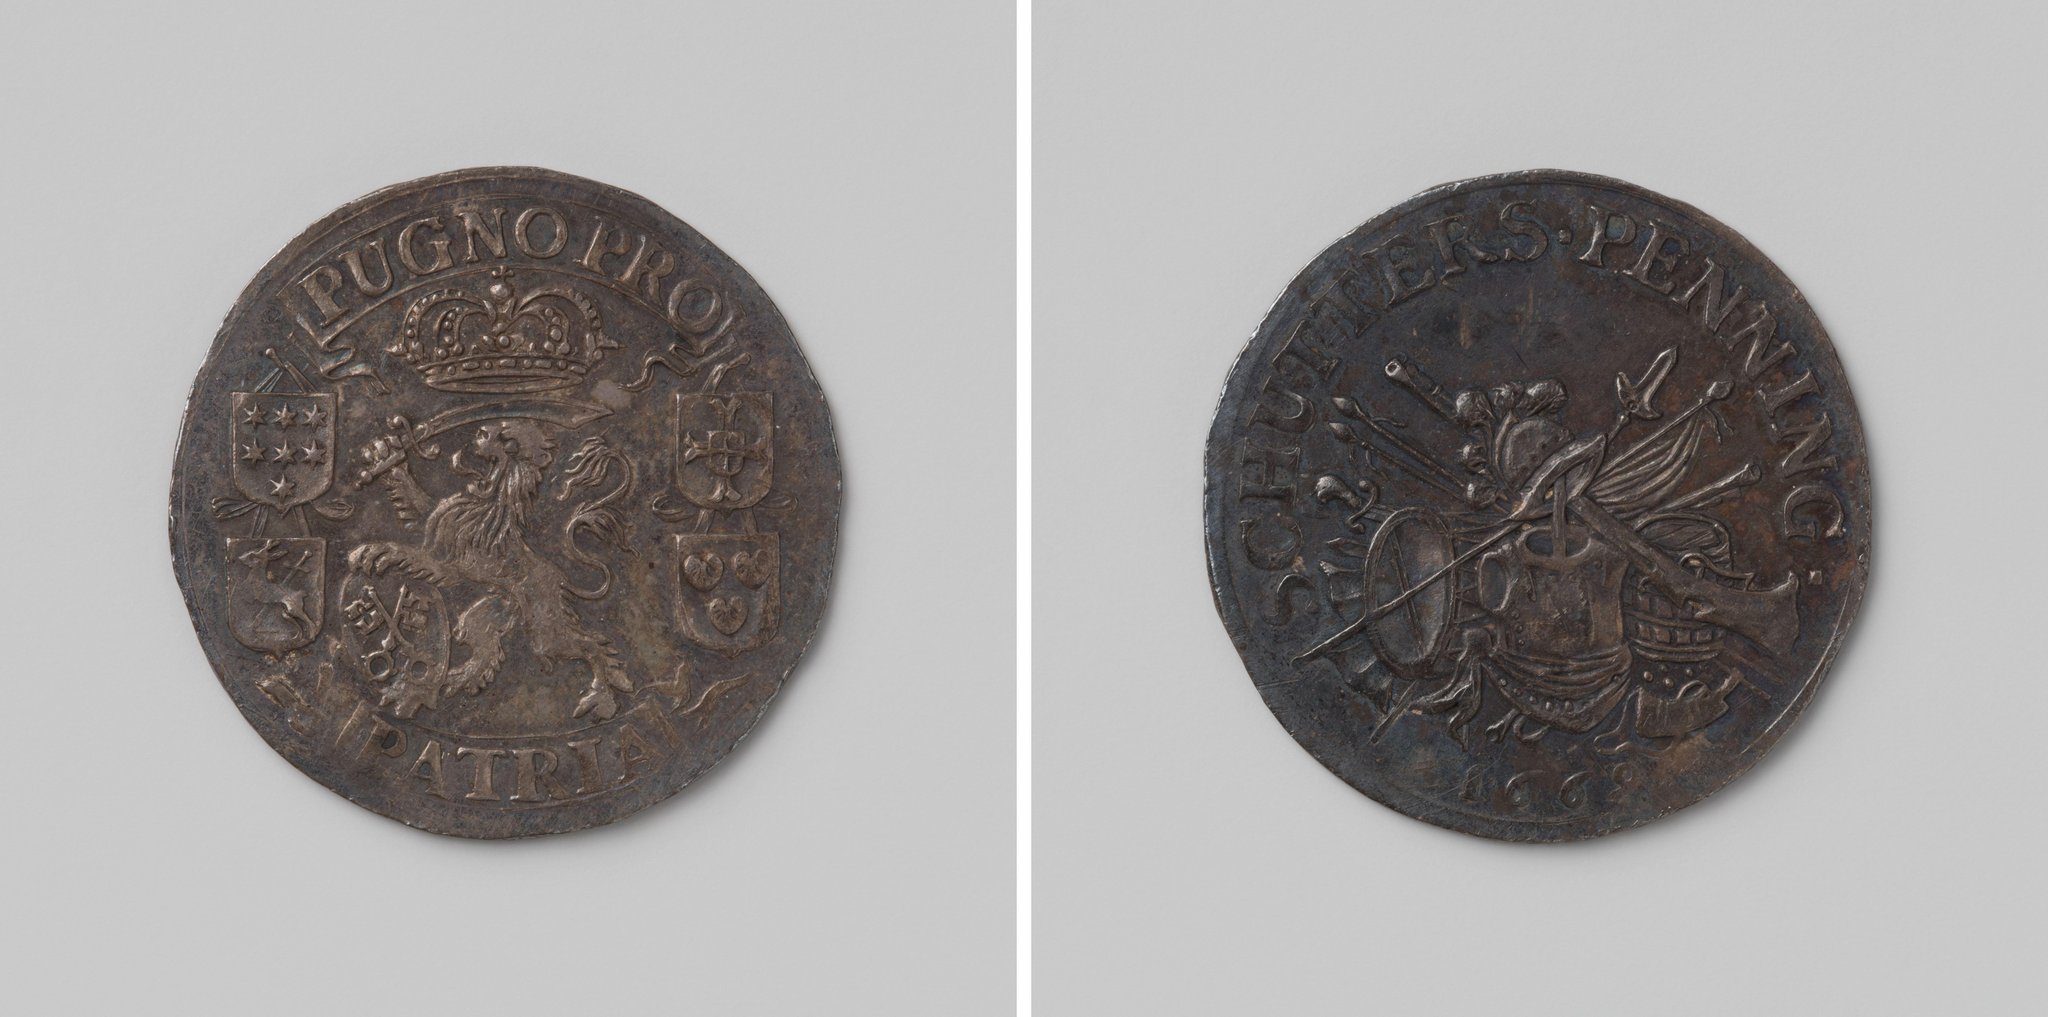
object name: marksman medal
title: Schutterij van Leiden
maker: arent jansz. schmeltzing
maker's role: medailleur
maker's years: 1639-1682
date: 1669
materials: silver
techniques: striking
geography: leiden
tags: leiden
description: Zilveren penning. Voorzijde: leeuw met zwaard in boven hoofd geheven rechterklauw en schild in linkerklauw onder kroon tussen vier wapenschilden binnen omschrift op wimpels. Keerzijde: wapentrophee bestaande uit harnas, trommel, vaandels en wapentuig boven jaartal binnen omschrift